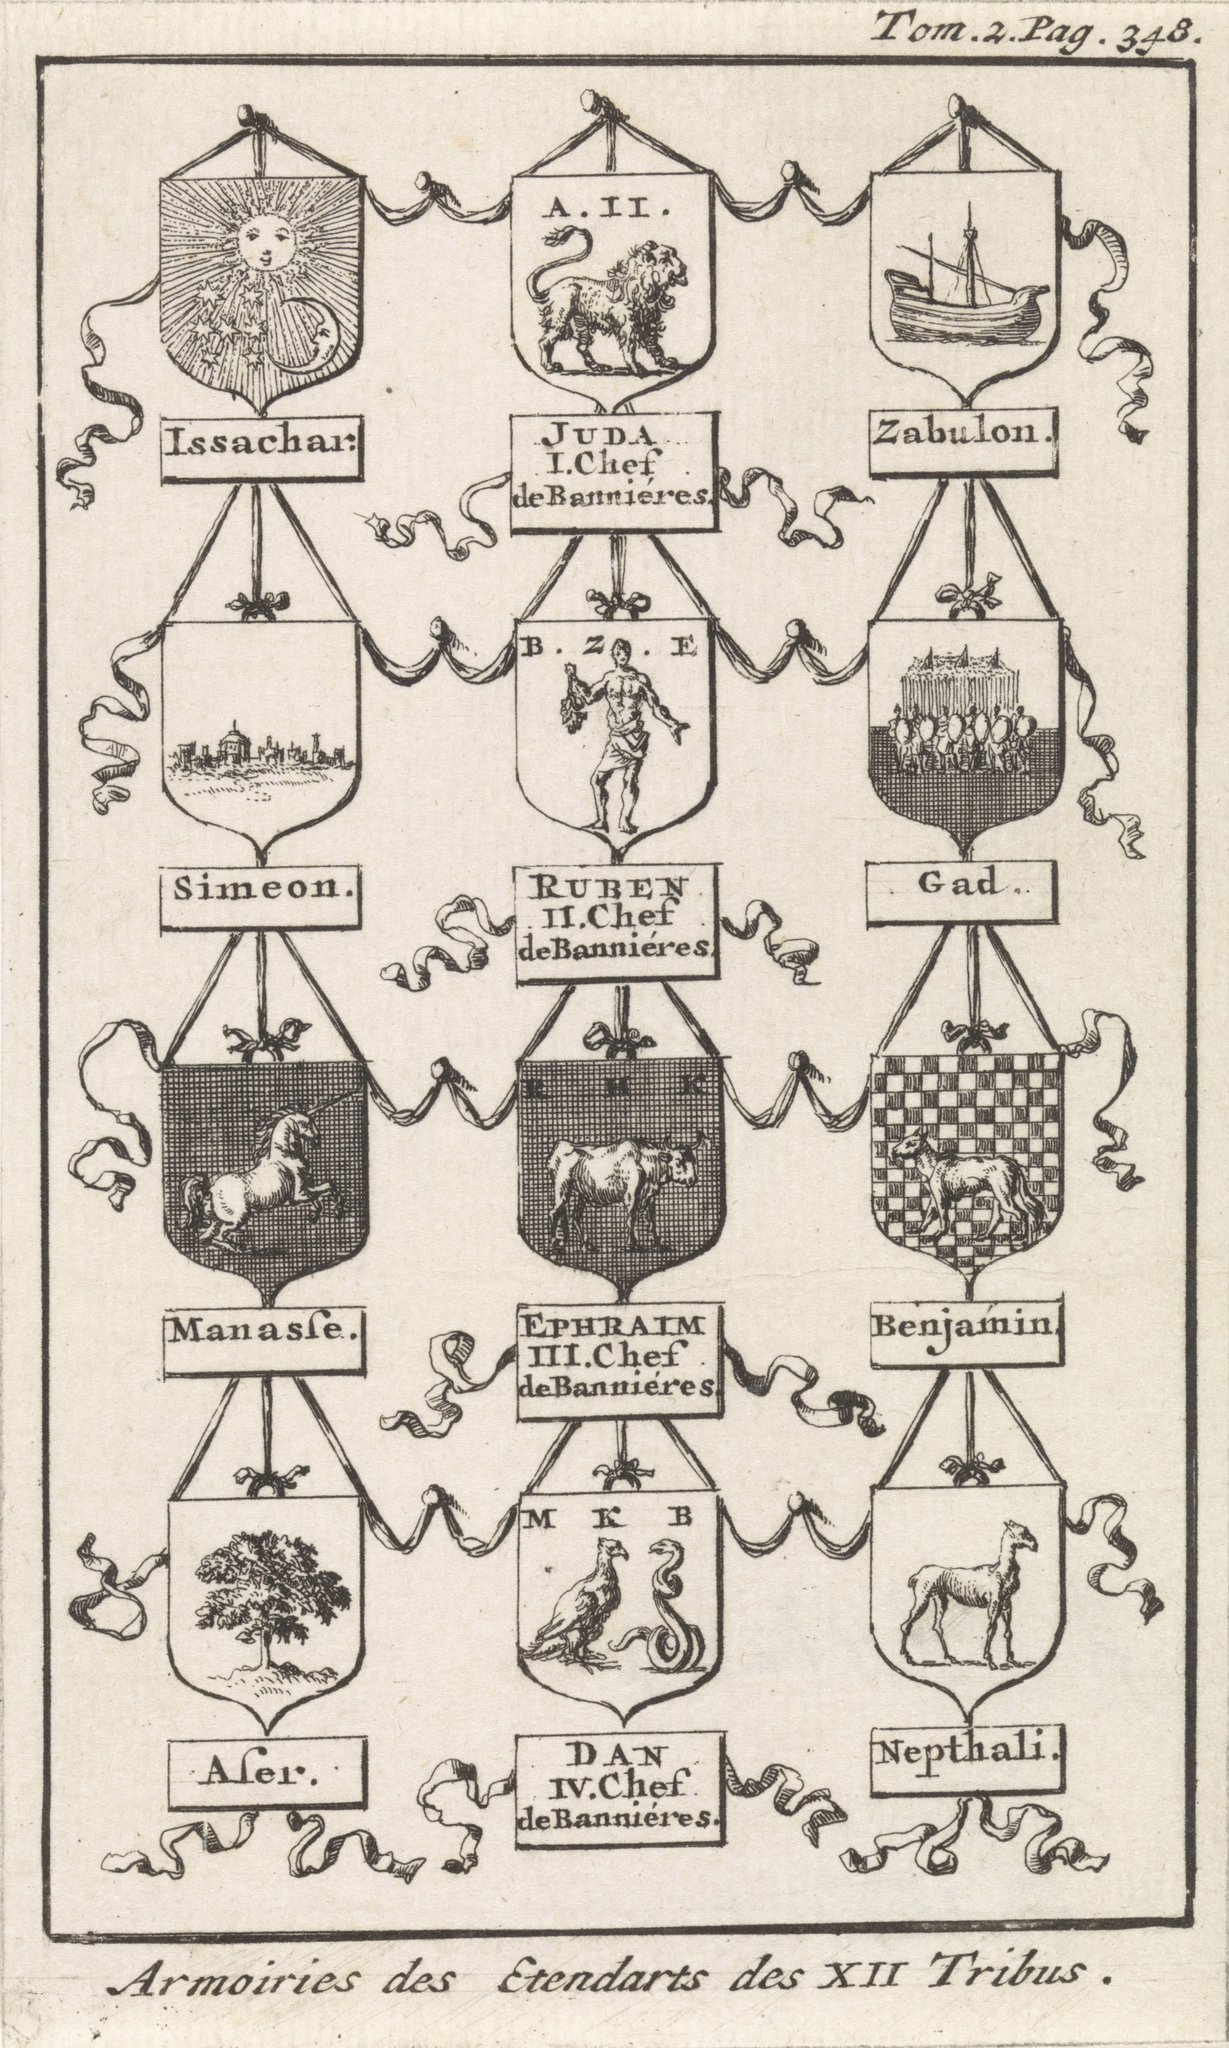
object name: print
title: Wapens van de twaalf stammen van Israël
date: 1705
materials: paper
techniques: etching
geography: amsterdam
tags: the twelve tribes of israel (not in biblical context)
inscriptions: collector's mark: Lugt 2228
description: Illustratie uit: Cunaeus, Petrus. La republique des Hebreux, 3 delen. Amsterdam: Pieter Mortier, 1705, dl. II, p. 348.